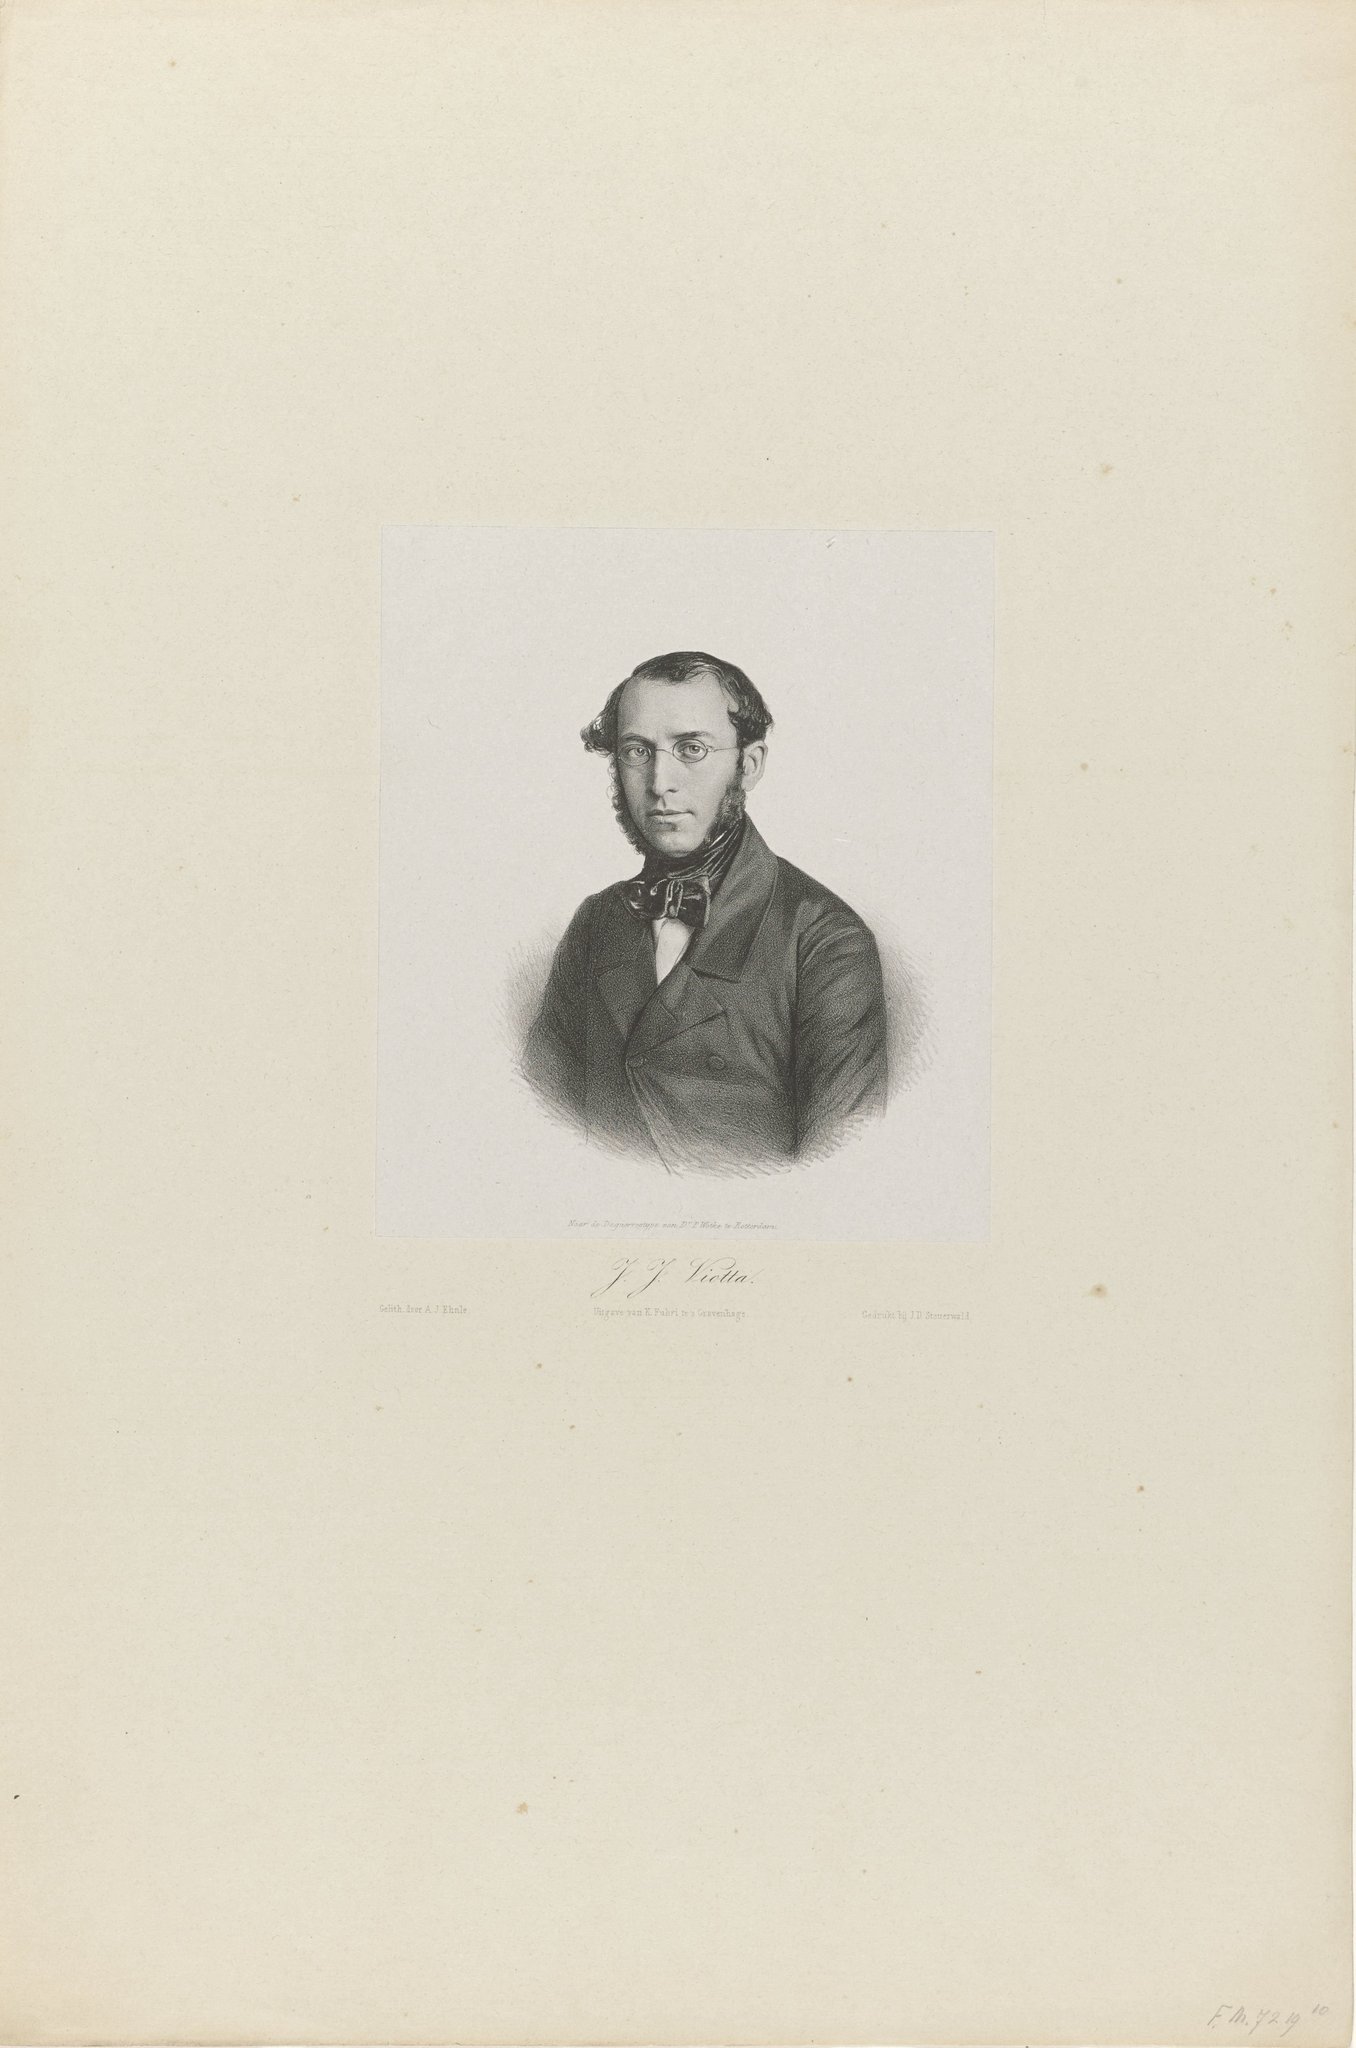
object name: print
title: De Maatschappij ter Bevordering van Toonkunst, haar Muziekfeest en de stad Rotterdam. herinnering aan het jaar 1854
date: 1855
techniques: printmaking, lithograph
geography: netherlands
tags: amsterdam, rotterdam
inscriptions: collector's mark: Lugt 2228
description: Portret van de componist J.J. Viotta, 1854. Onderdeel van een serie van twaalf portretten naar daguerrotypieën en twaalf stadsgezichten. Ter gelegenheid van het Muziekfeest ter viering van het 25-jarige bestaan van de Maatschappij ter Bevordering van Toonkunst in Rotterdam, 12-15 juli 1854.